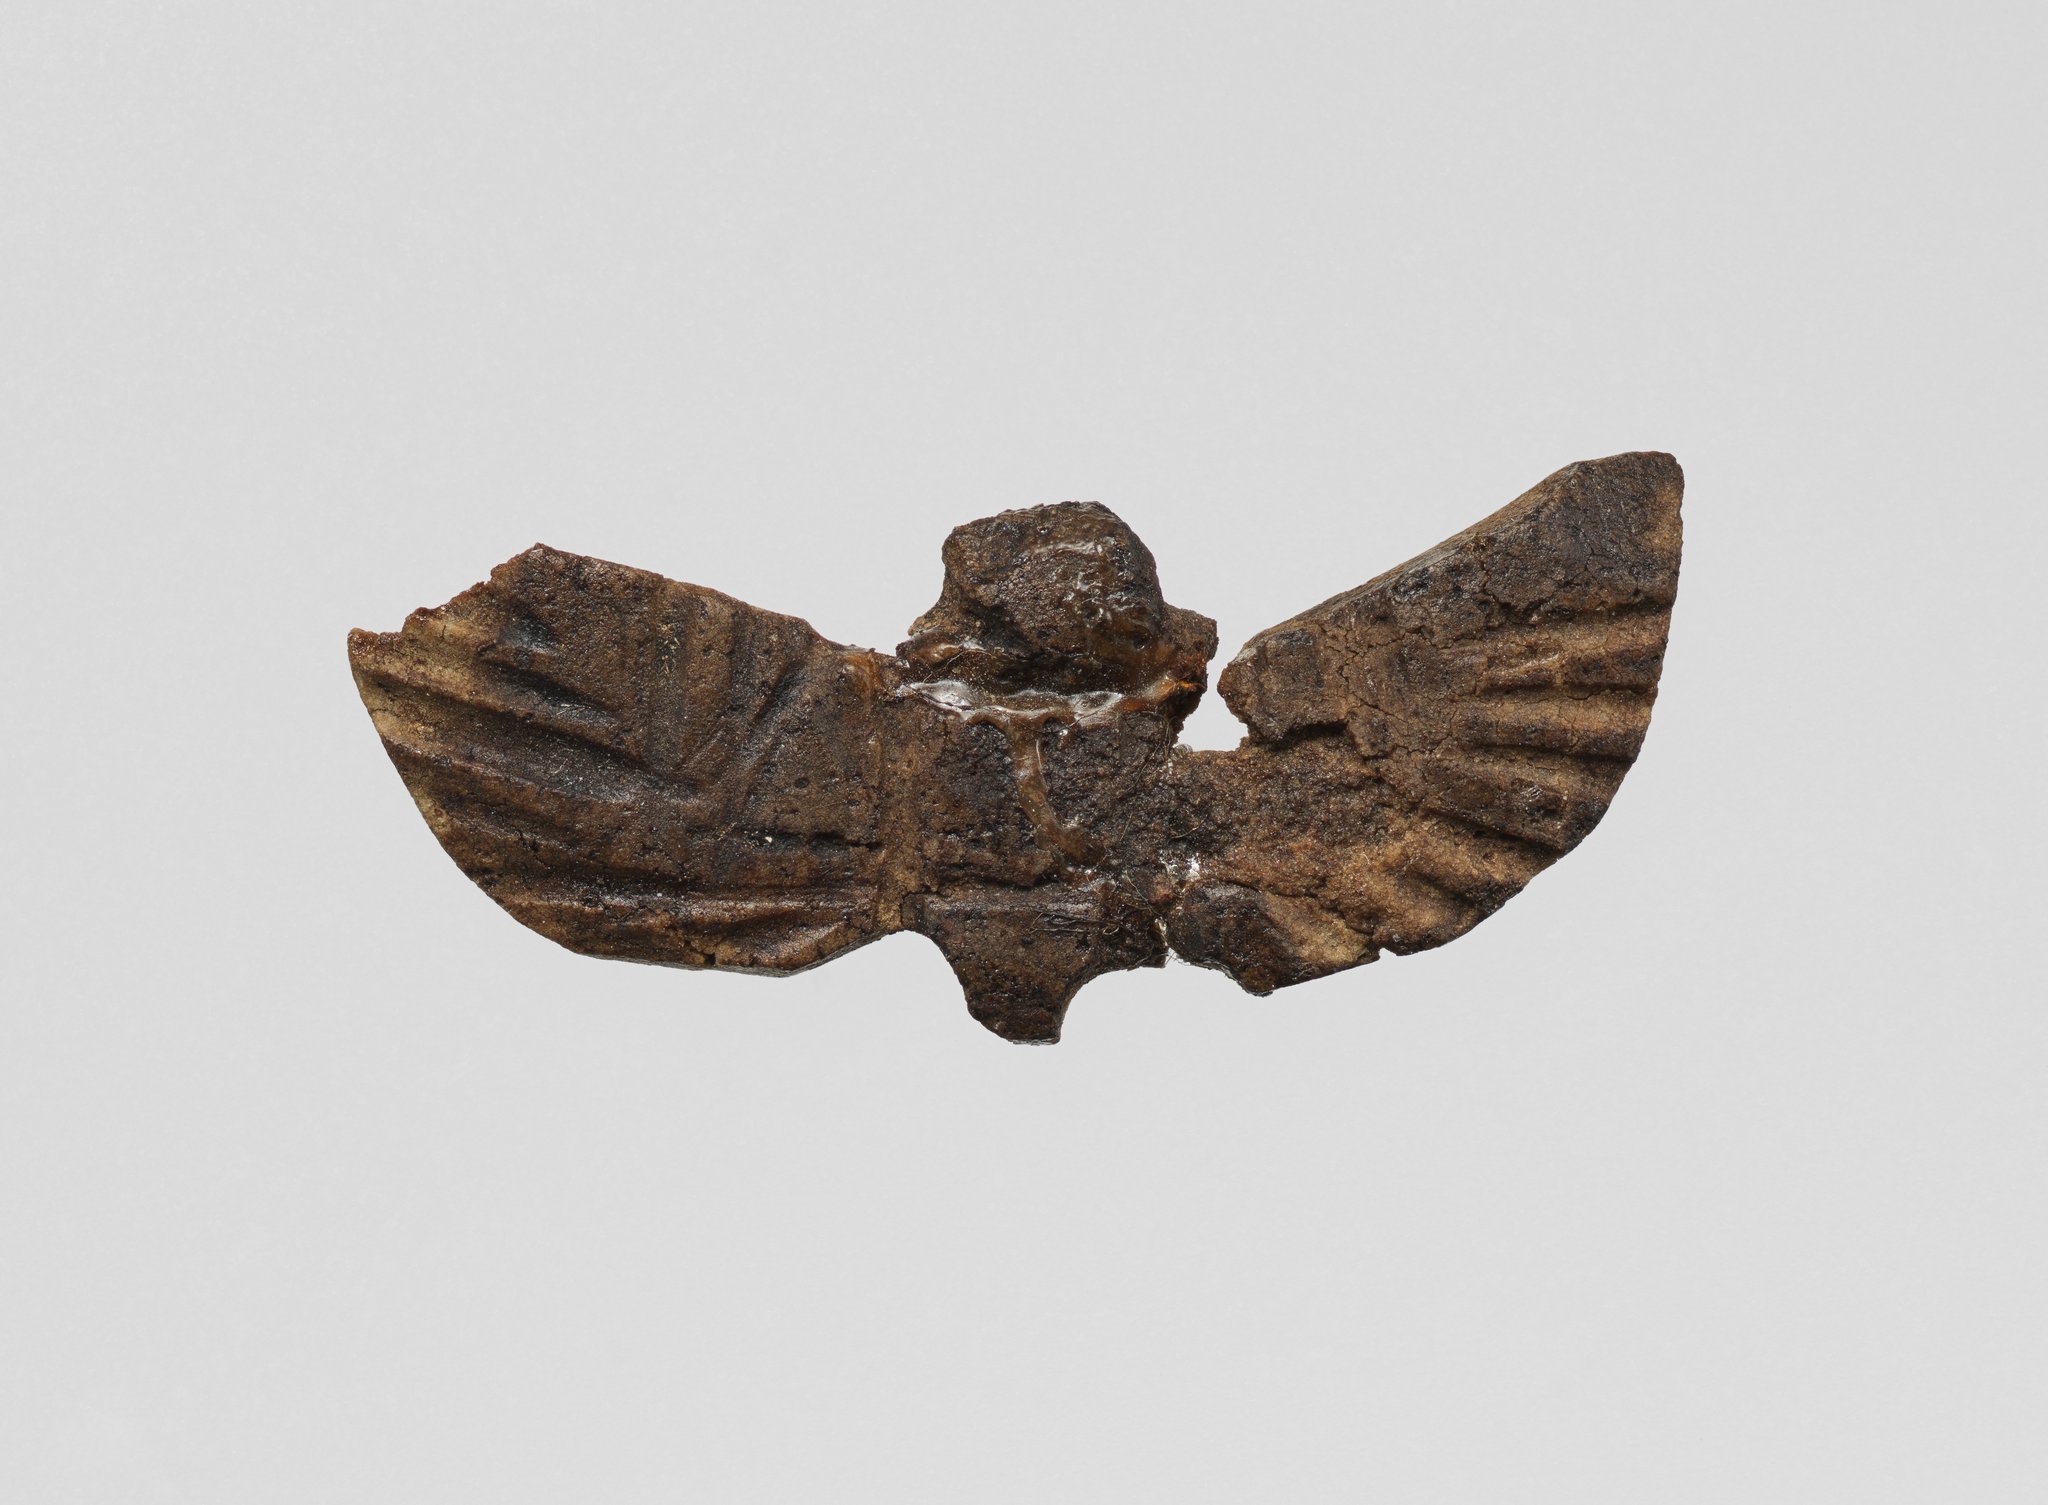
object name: amulet, ba bird, isetweret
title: Ba-Bird Amulet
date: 305-30 BCE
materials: faience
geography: egypt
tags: birds